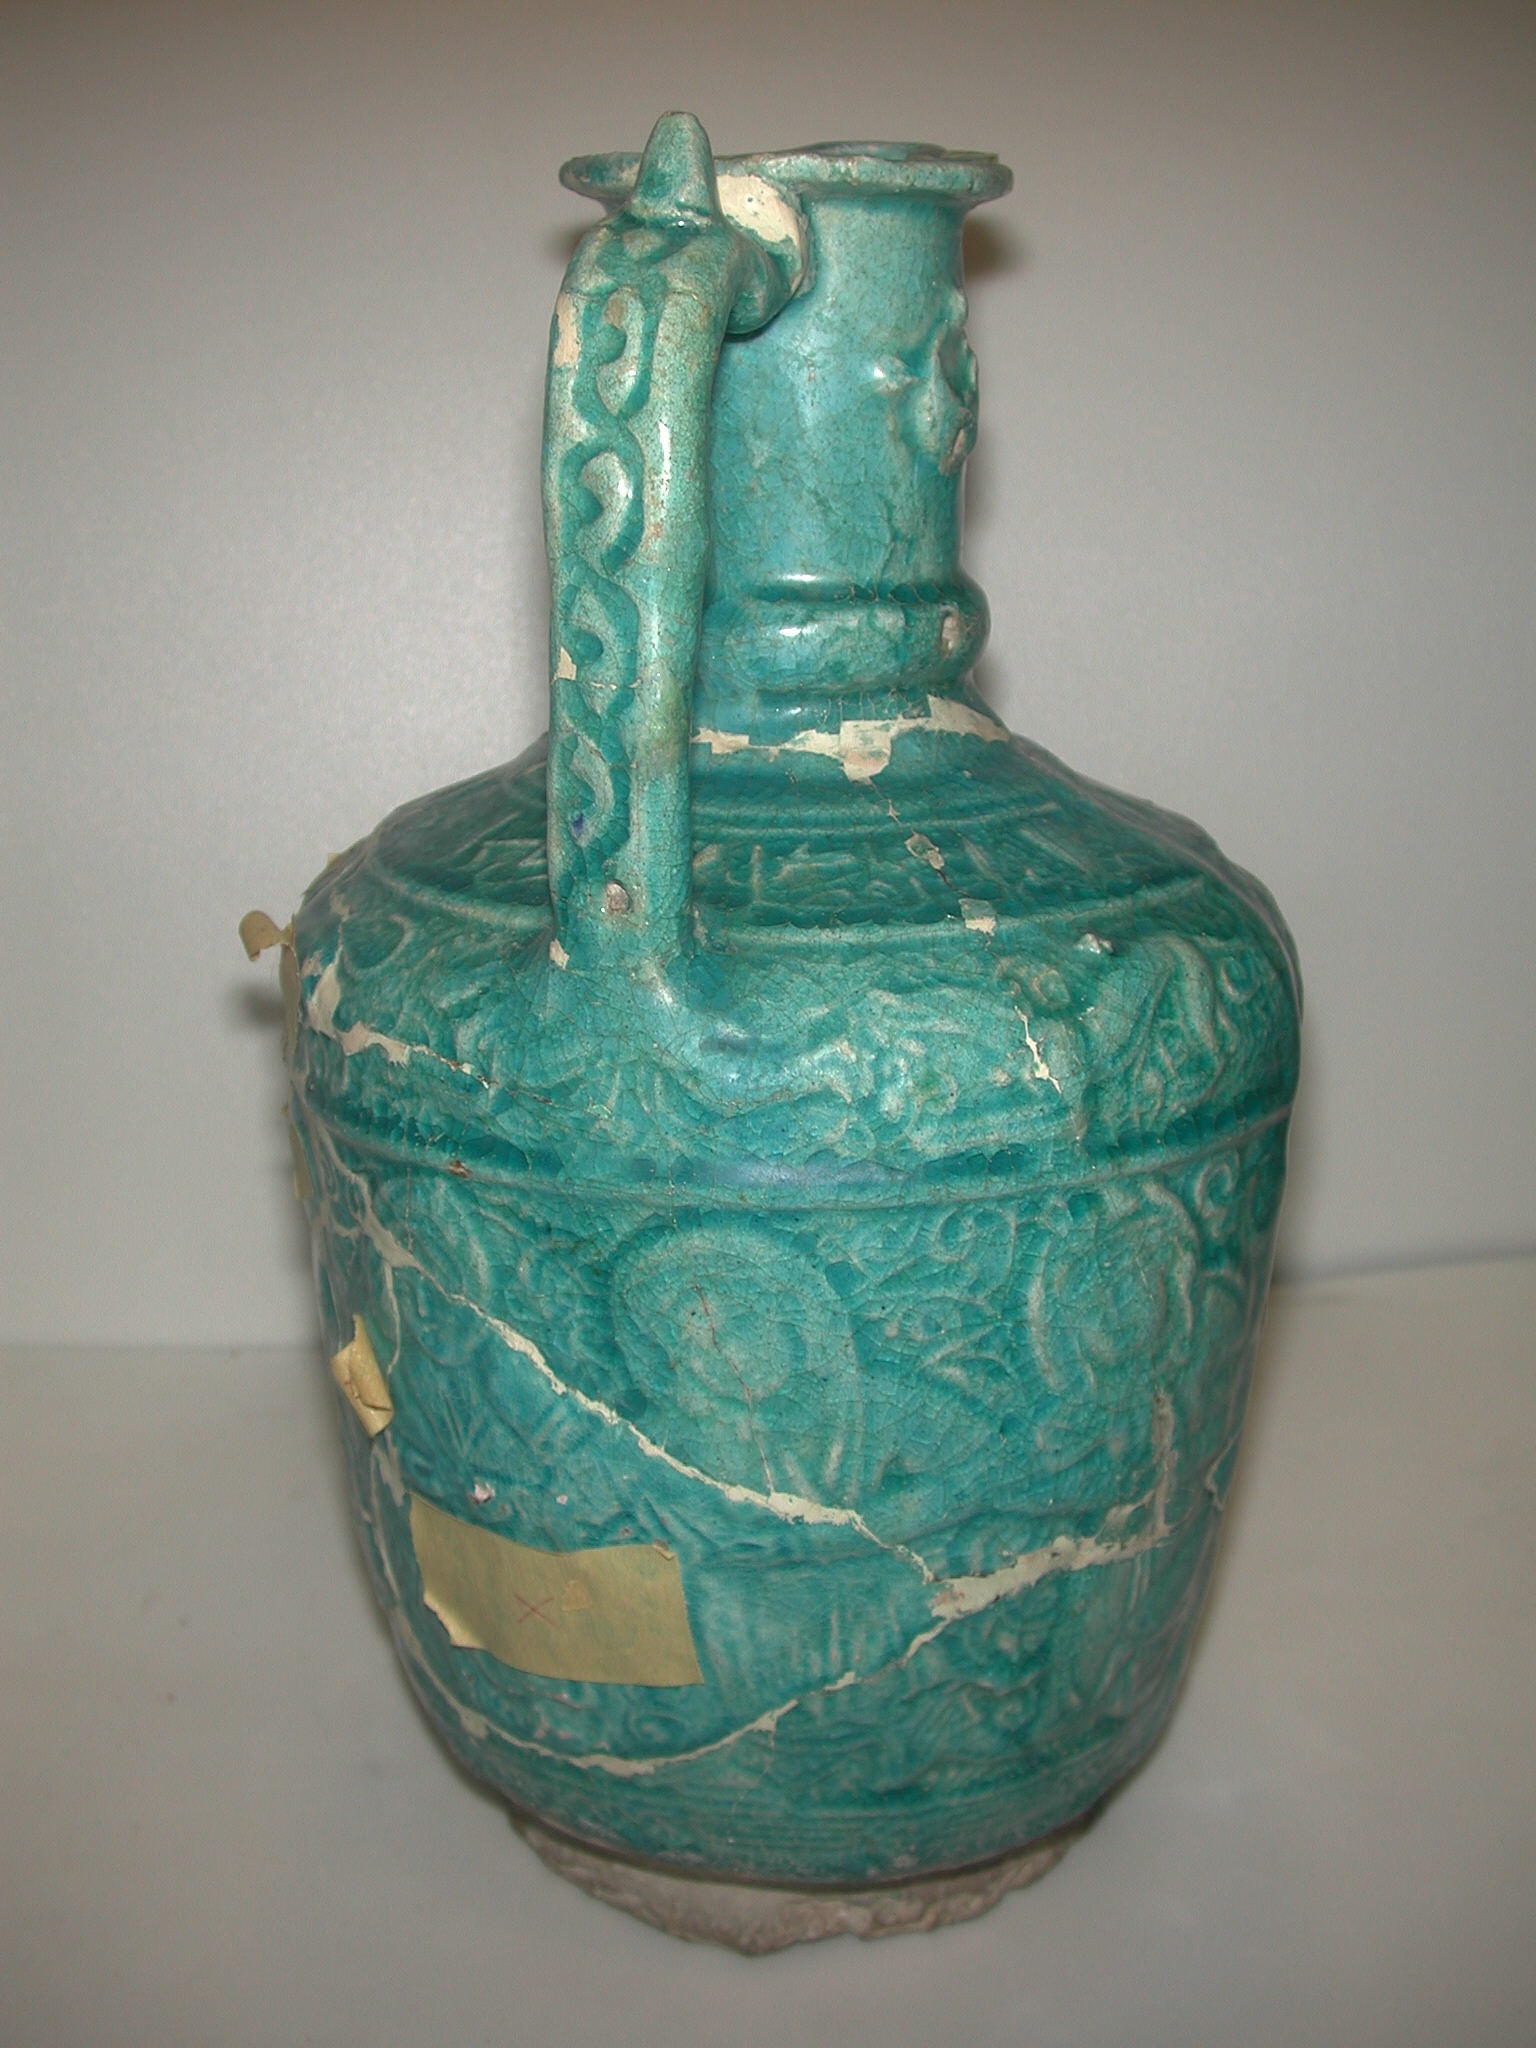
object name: ewer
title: Ewer with Molded Inscriptions, Animals, and Dancers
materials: stonepaste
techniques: glazing, molding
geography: iran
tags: human figures,dancers